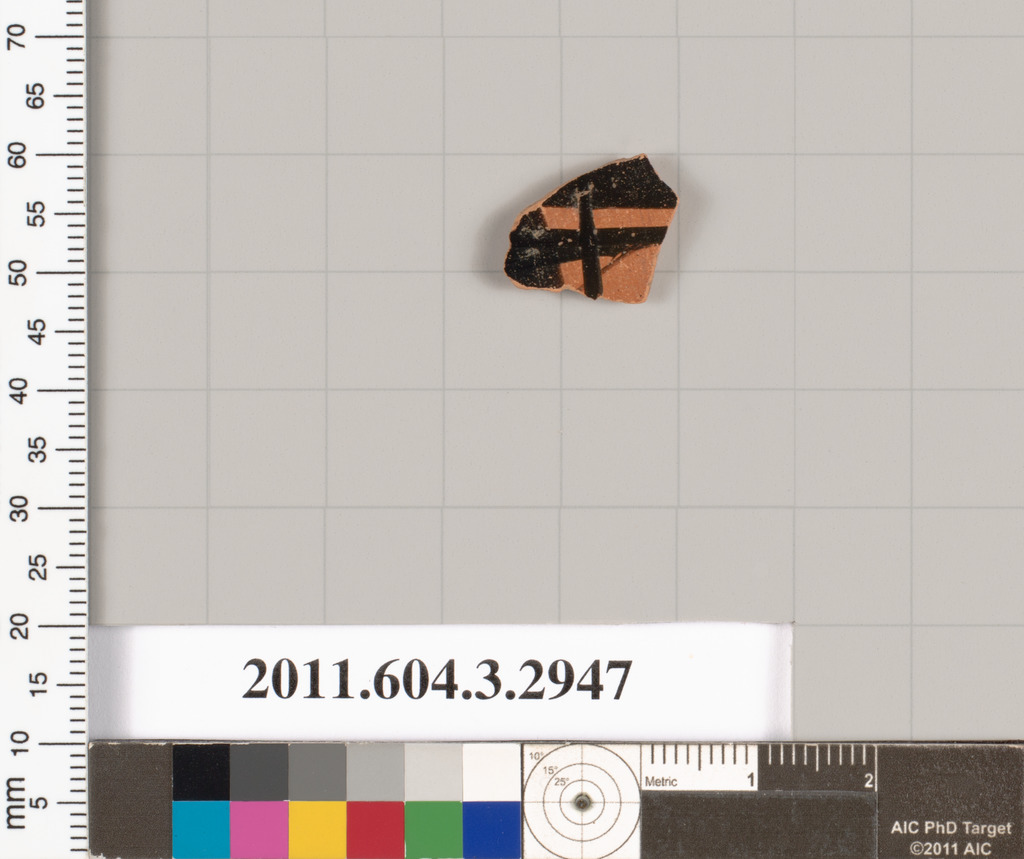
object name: oinochoe or olpe fragment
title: Terracotta fragment of an oinochoe (jug)?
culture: greek, attic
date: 534-468 BCE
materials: terracotta